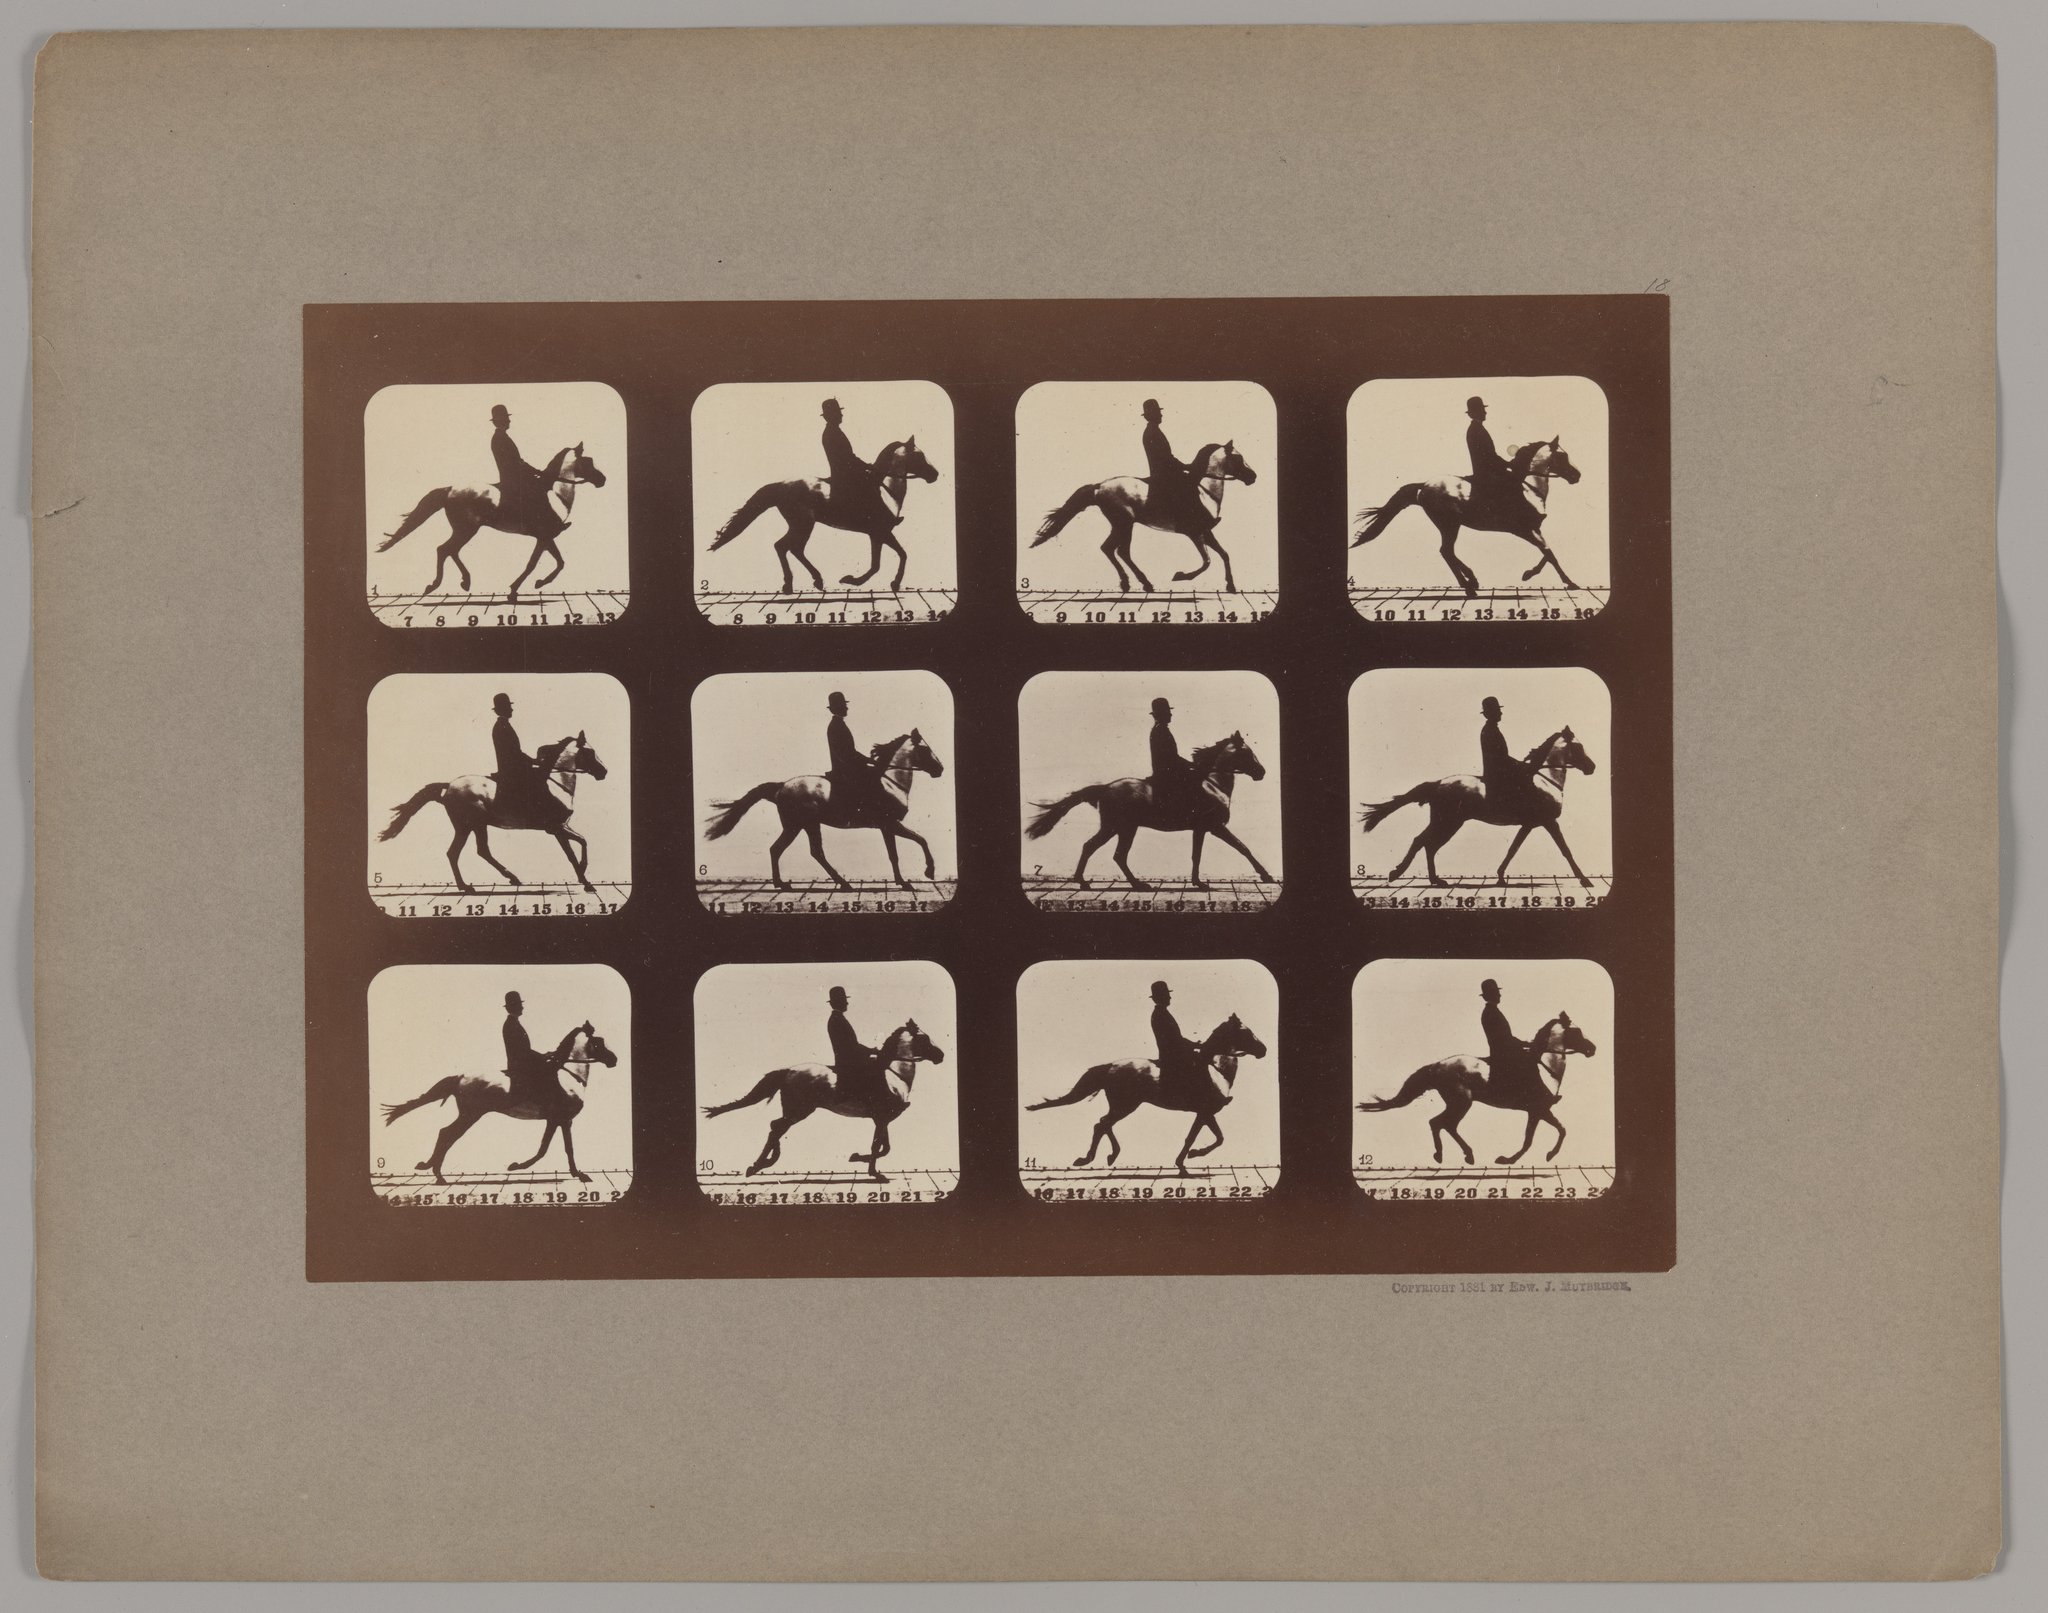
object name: photograph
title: Attitudes of Animals in Motion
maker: eadweard muybridge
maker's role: artist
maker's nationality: british and american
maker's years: 1830-1904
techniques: albumen silver print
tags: horses